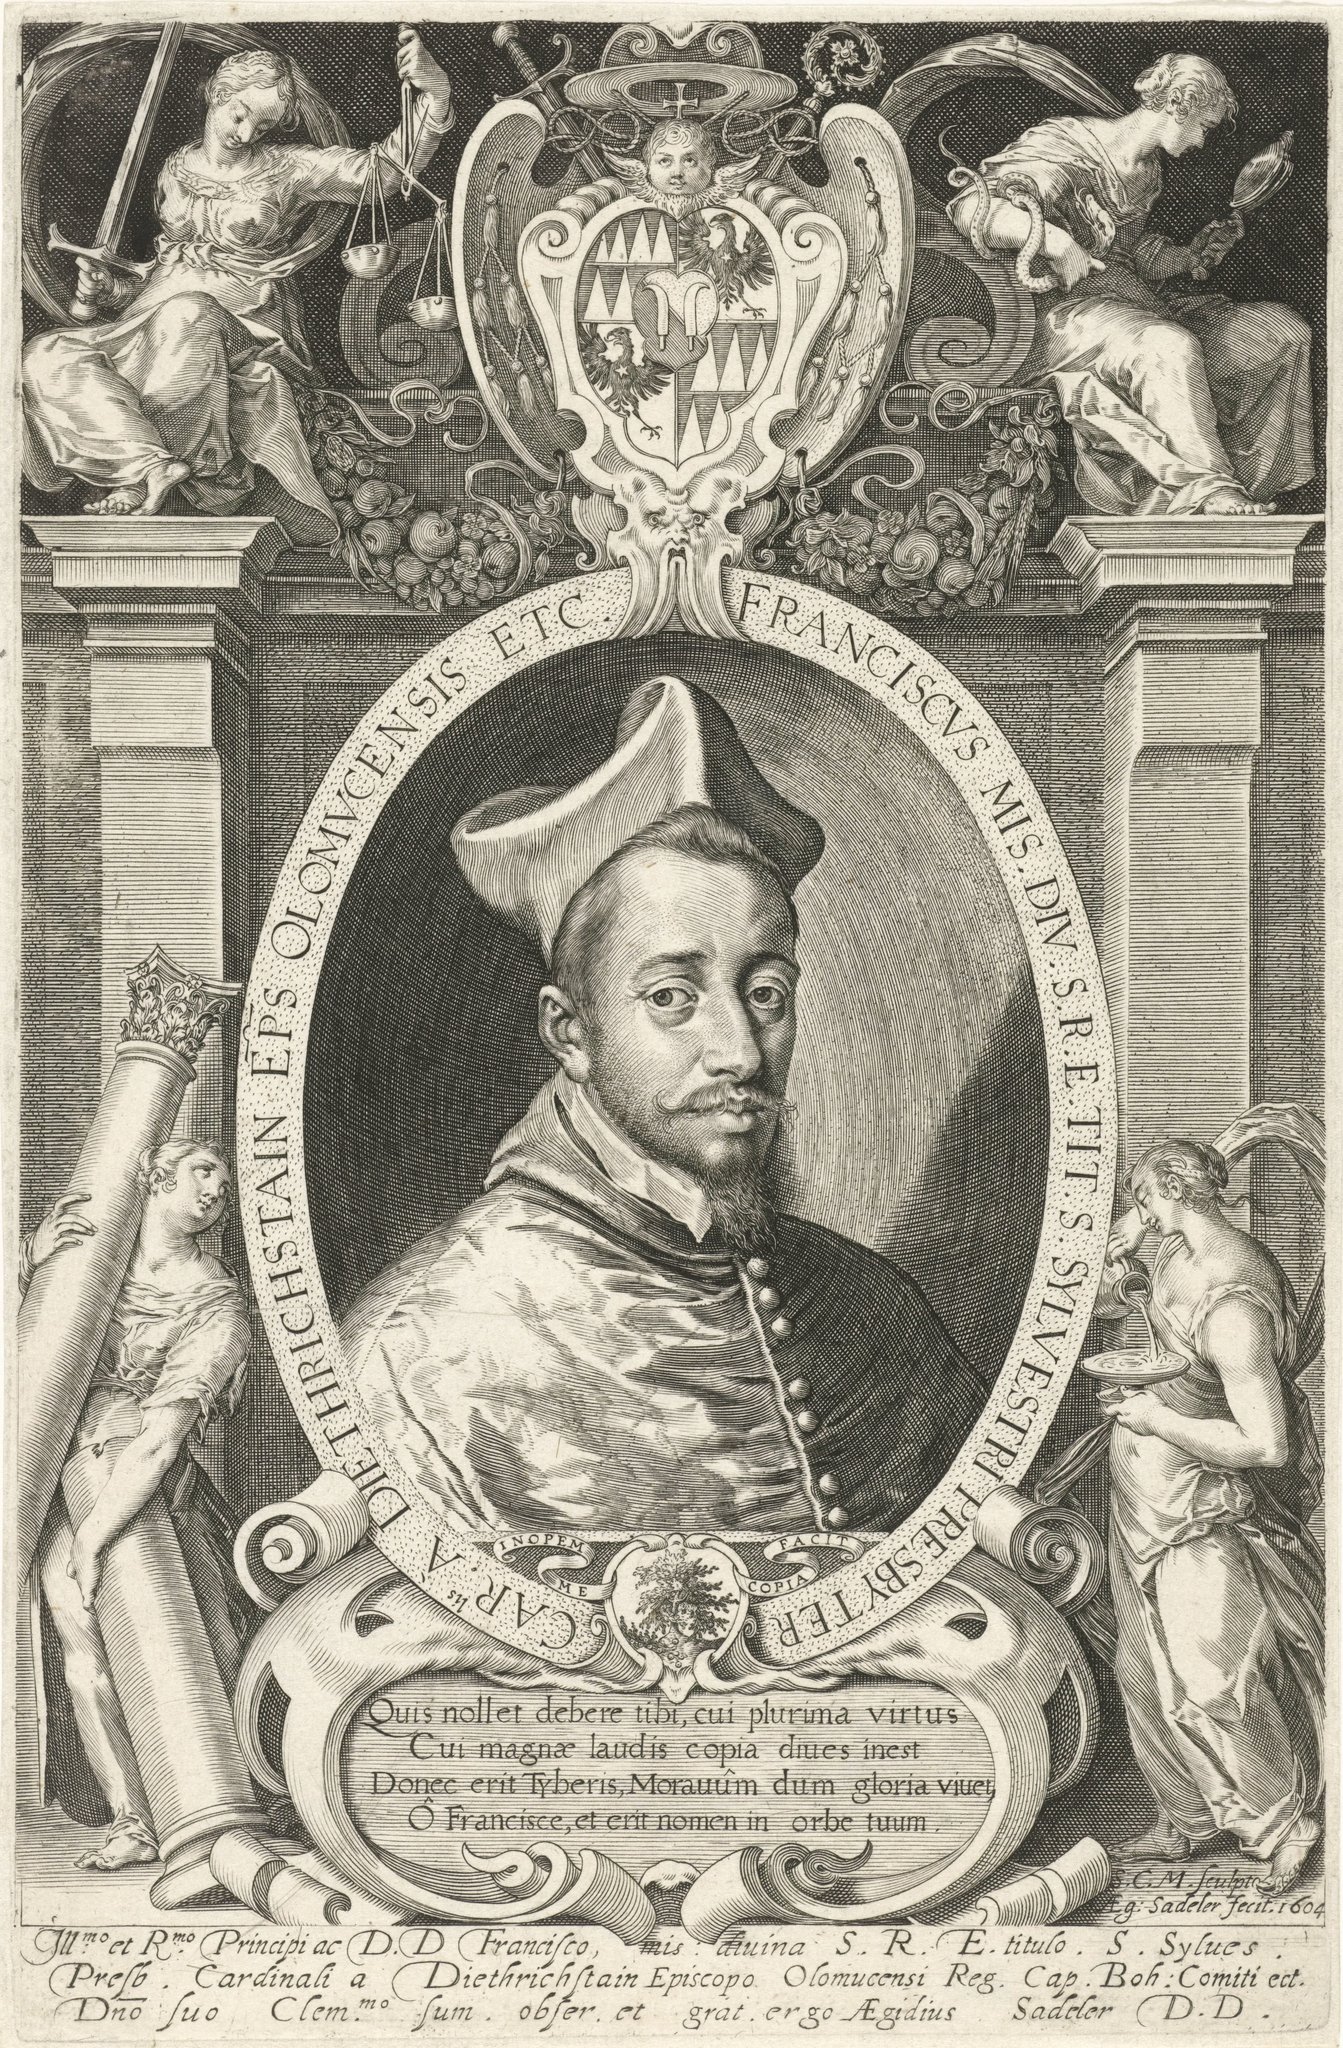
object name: print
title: Portret van bisschop Franz von Dietrichstein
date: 1604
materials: paper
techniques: engraving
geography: prague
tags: franz seraph von dietrichstein, the four cardinal virtues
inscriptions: collector's mark: Lugt 240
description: Franz von Dietrichstein, bisschop van Olmütz. Rondom het portret de vier kardinale deugden: Rechtvaardigheid, Voorzichtigheid, Kracht en Matigheid. De prent heeft twee Latijnse onderschriften.